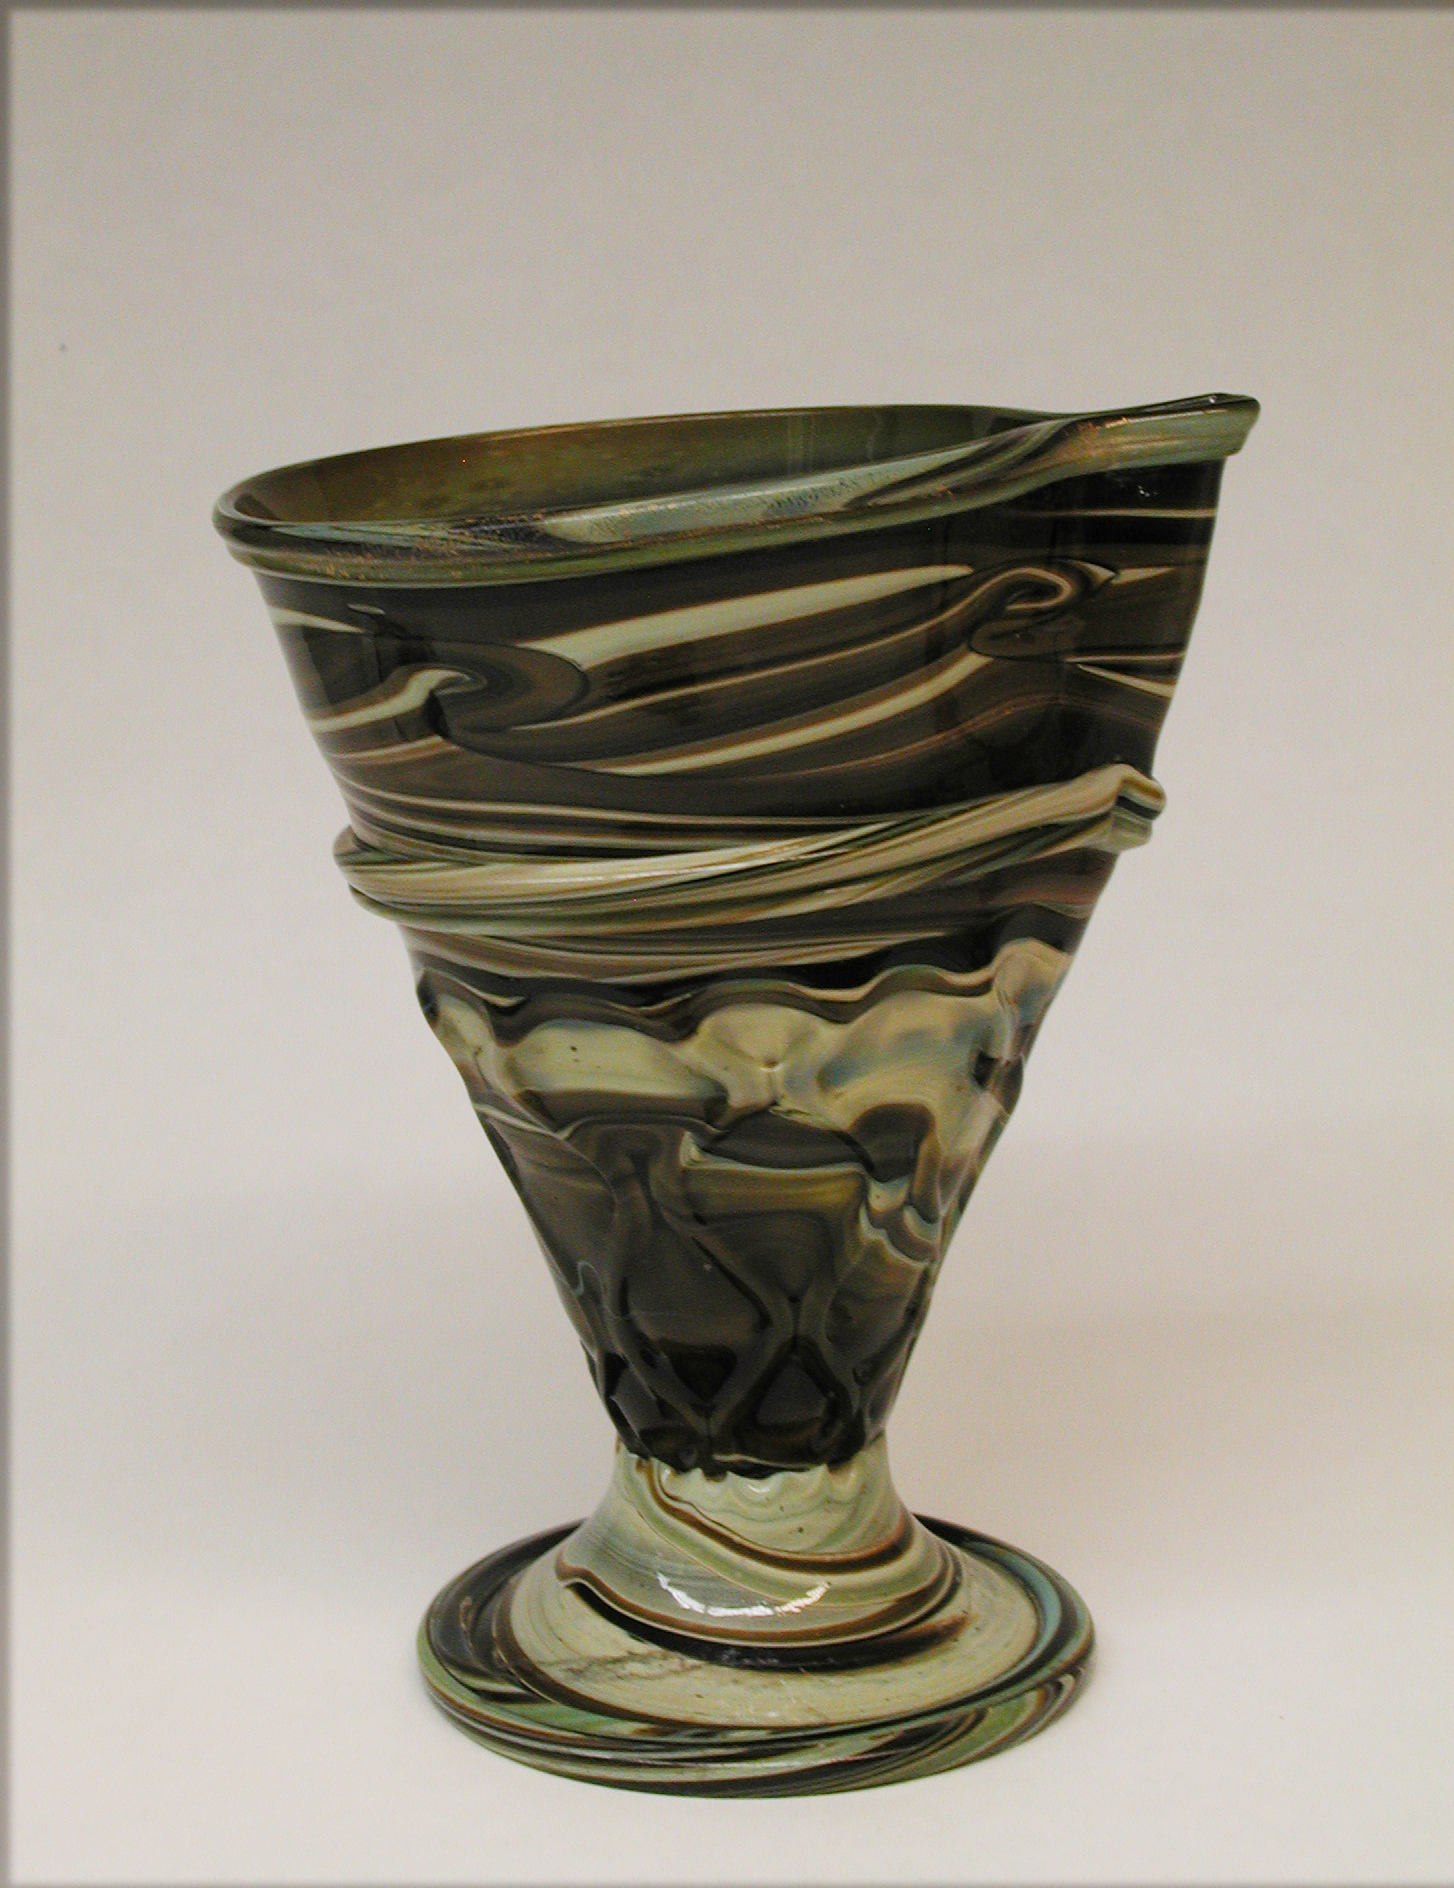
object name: jug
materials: glass